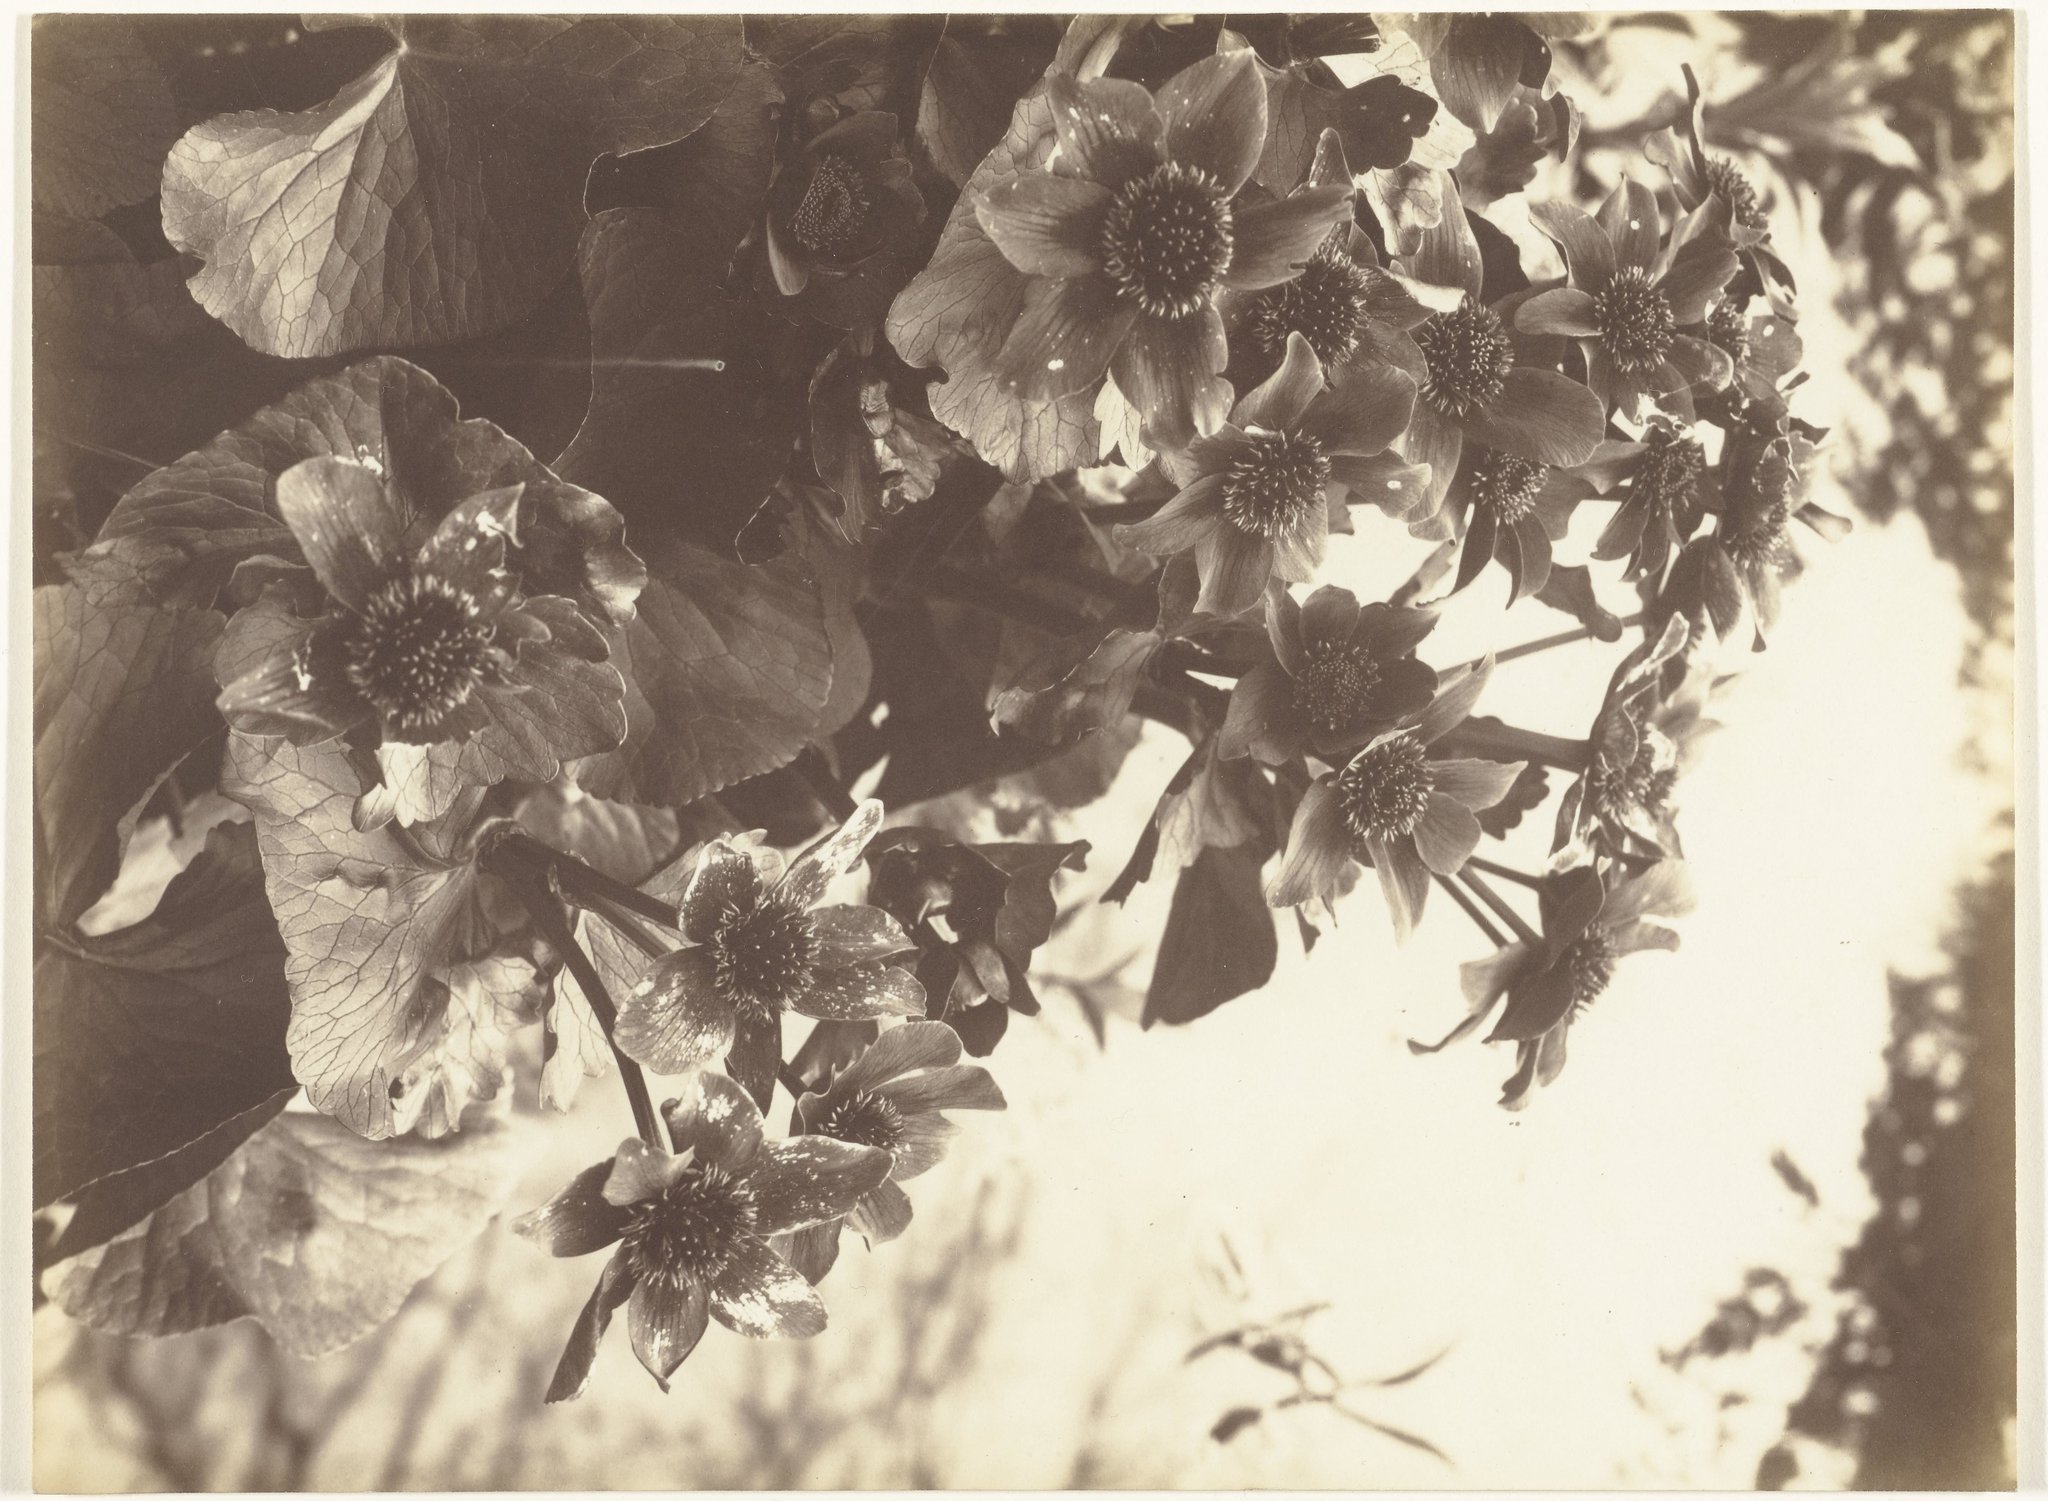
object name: photograph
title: Plantstilleven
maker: richard tepe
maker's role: fotograaf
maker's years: 1864-1952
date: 1900-1930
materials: photographic support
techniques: gelatin silver print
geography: netherlands